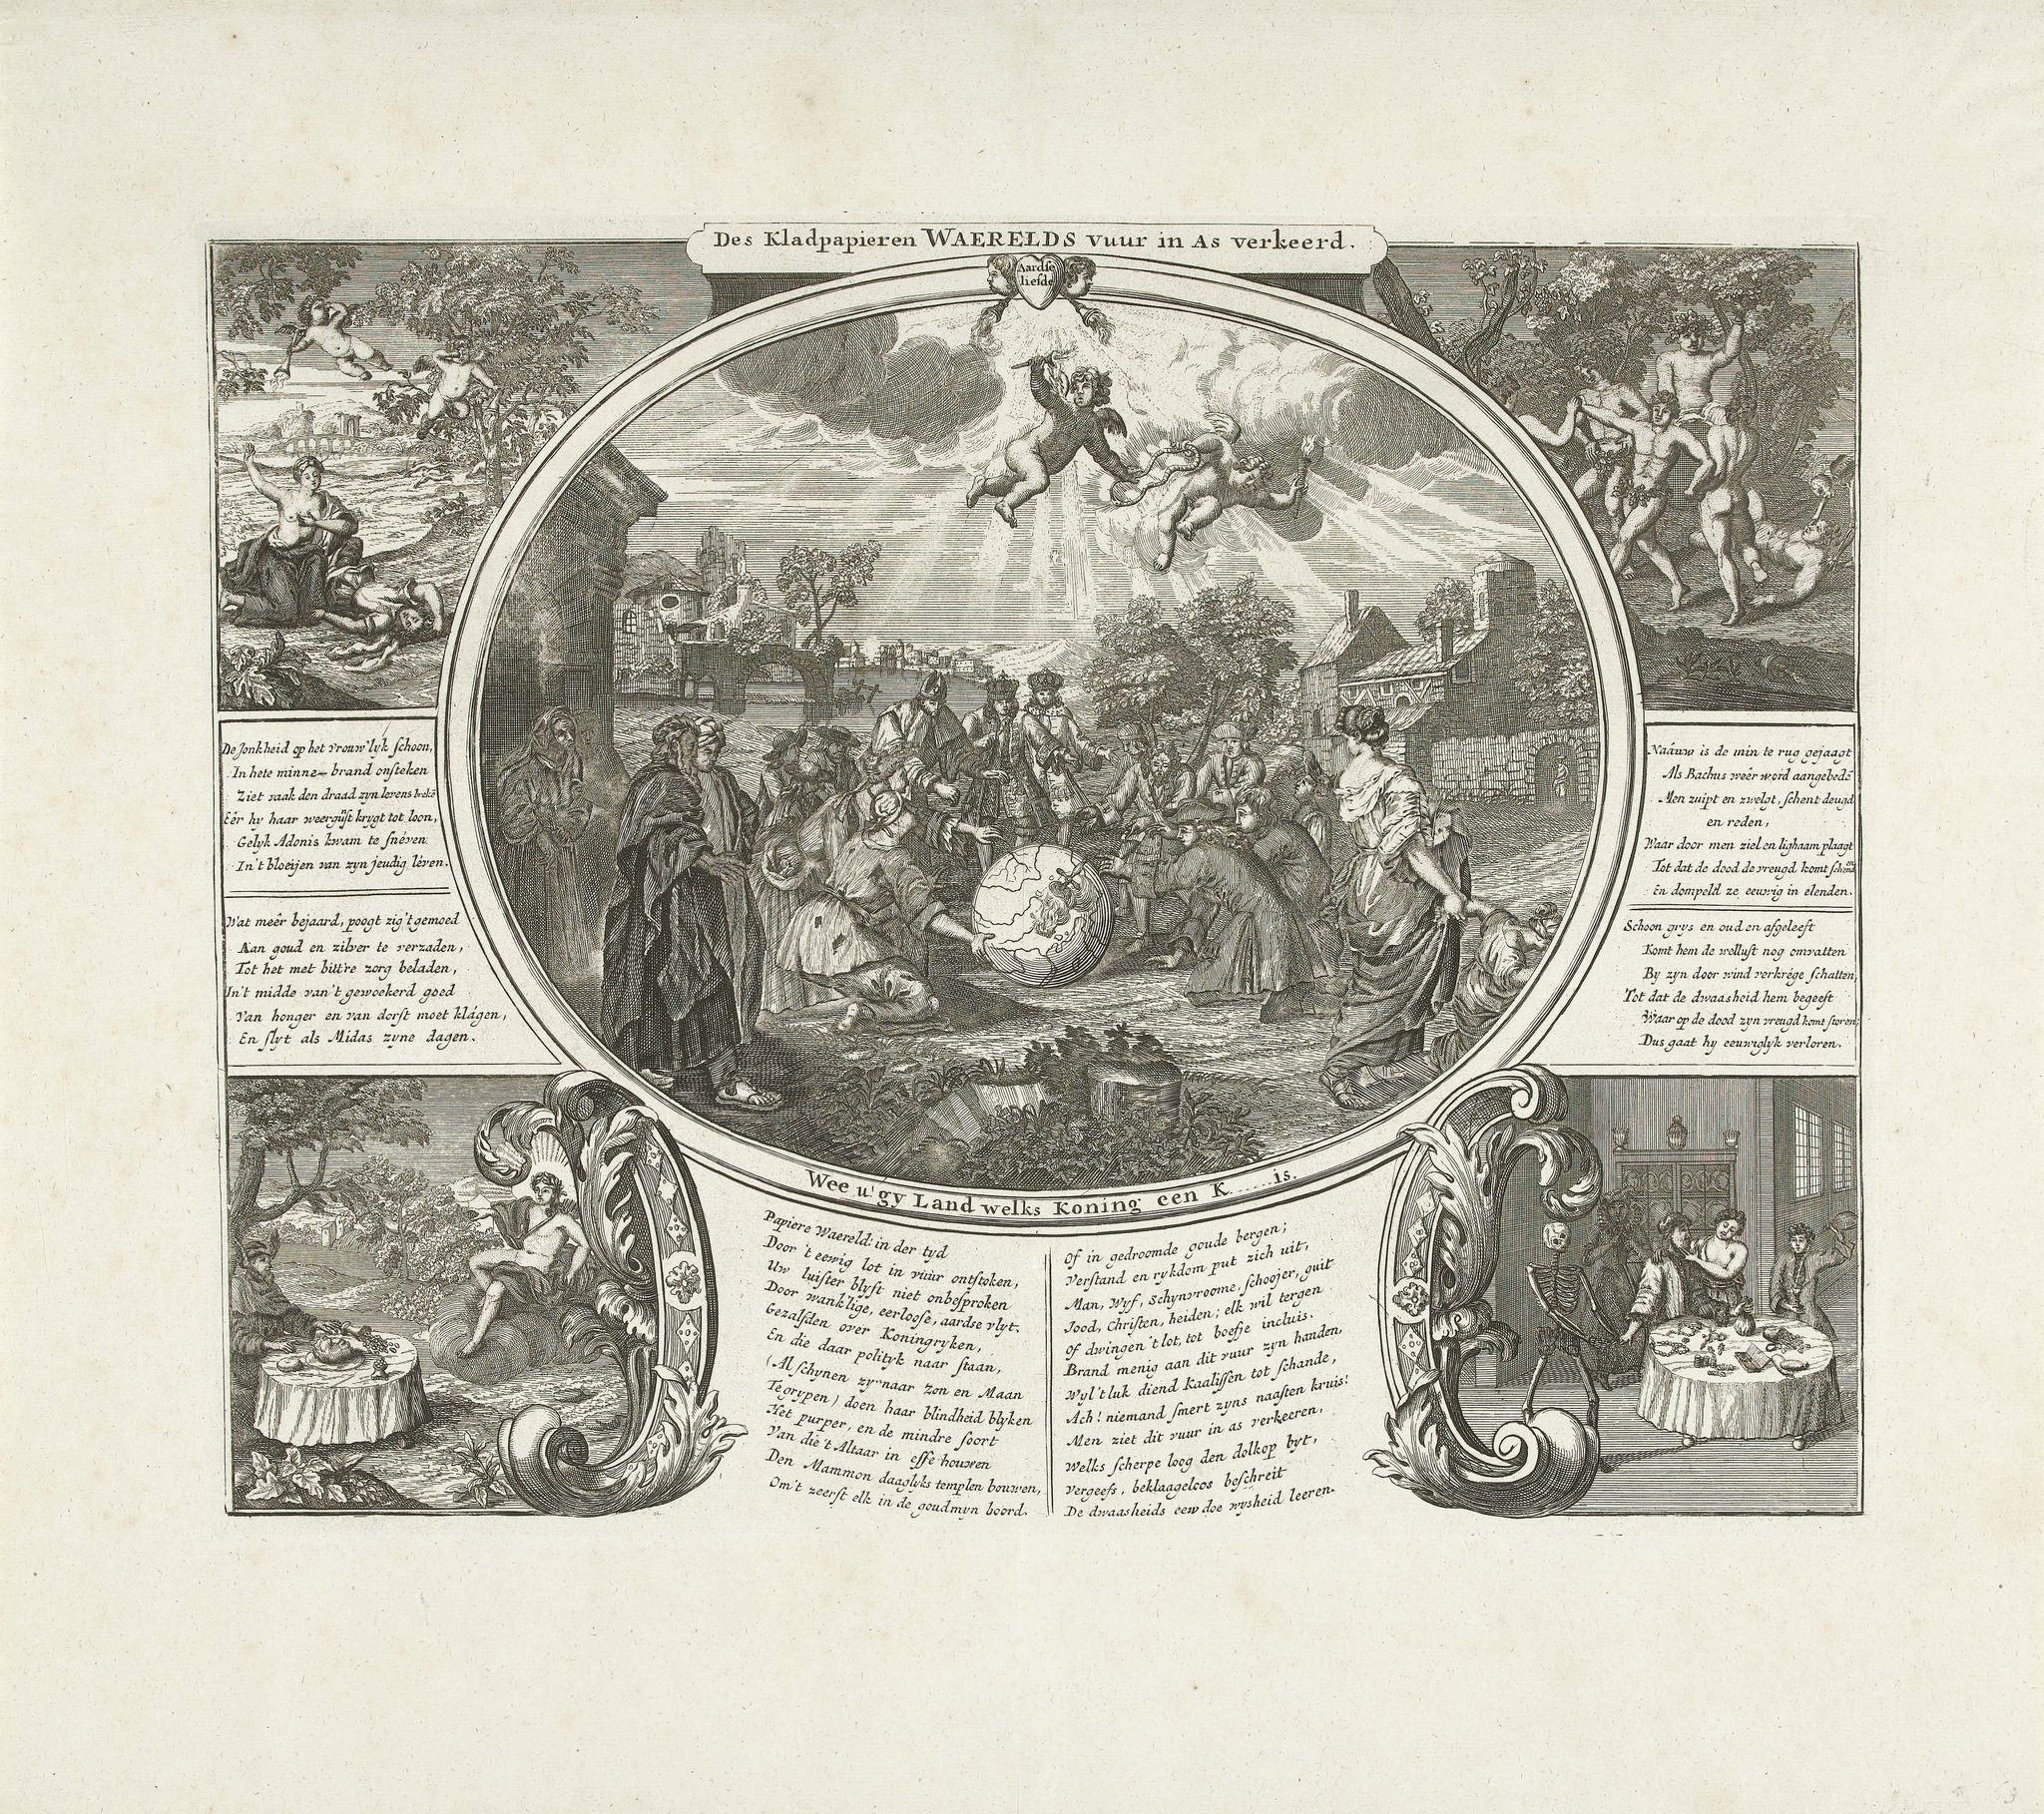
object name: cartoon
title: De kladpapieren wereld in brand, 1720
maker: Anonymous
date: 1720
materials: paper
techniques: engraving, etching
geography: northern netherlands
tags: scenes symbolizing 'vanitas'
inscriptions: collector's mark: Lugt 2228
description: Centrale voorstelling met de wereldlijke en geestelijke vorsten en allerlei ander volk van arm tot rijk zijn verzameld om een wereldbol die vlam vat. In de vier hoeken illsutraties van de vluchtigheid van de wereldse genoegens. Met meerdere verzen. Prent 63 in de serie Het Groote Tafereel der Dwaasheid met spotprenten op de Windhandel of Actiehandel van 1720.